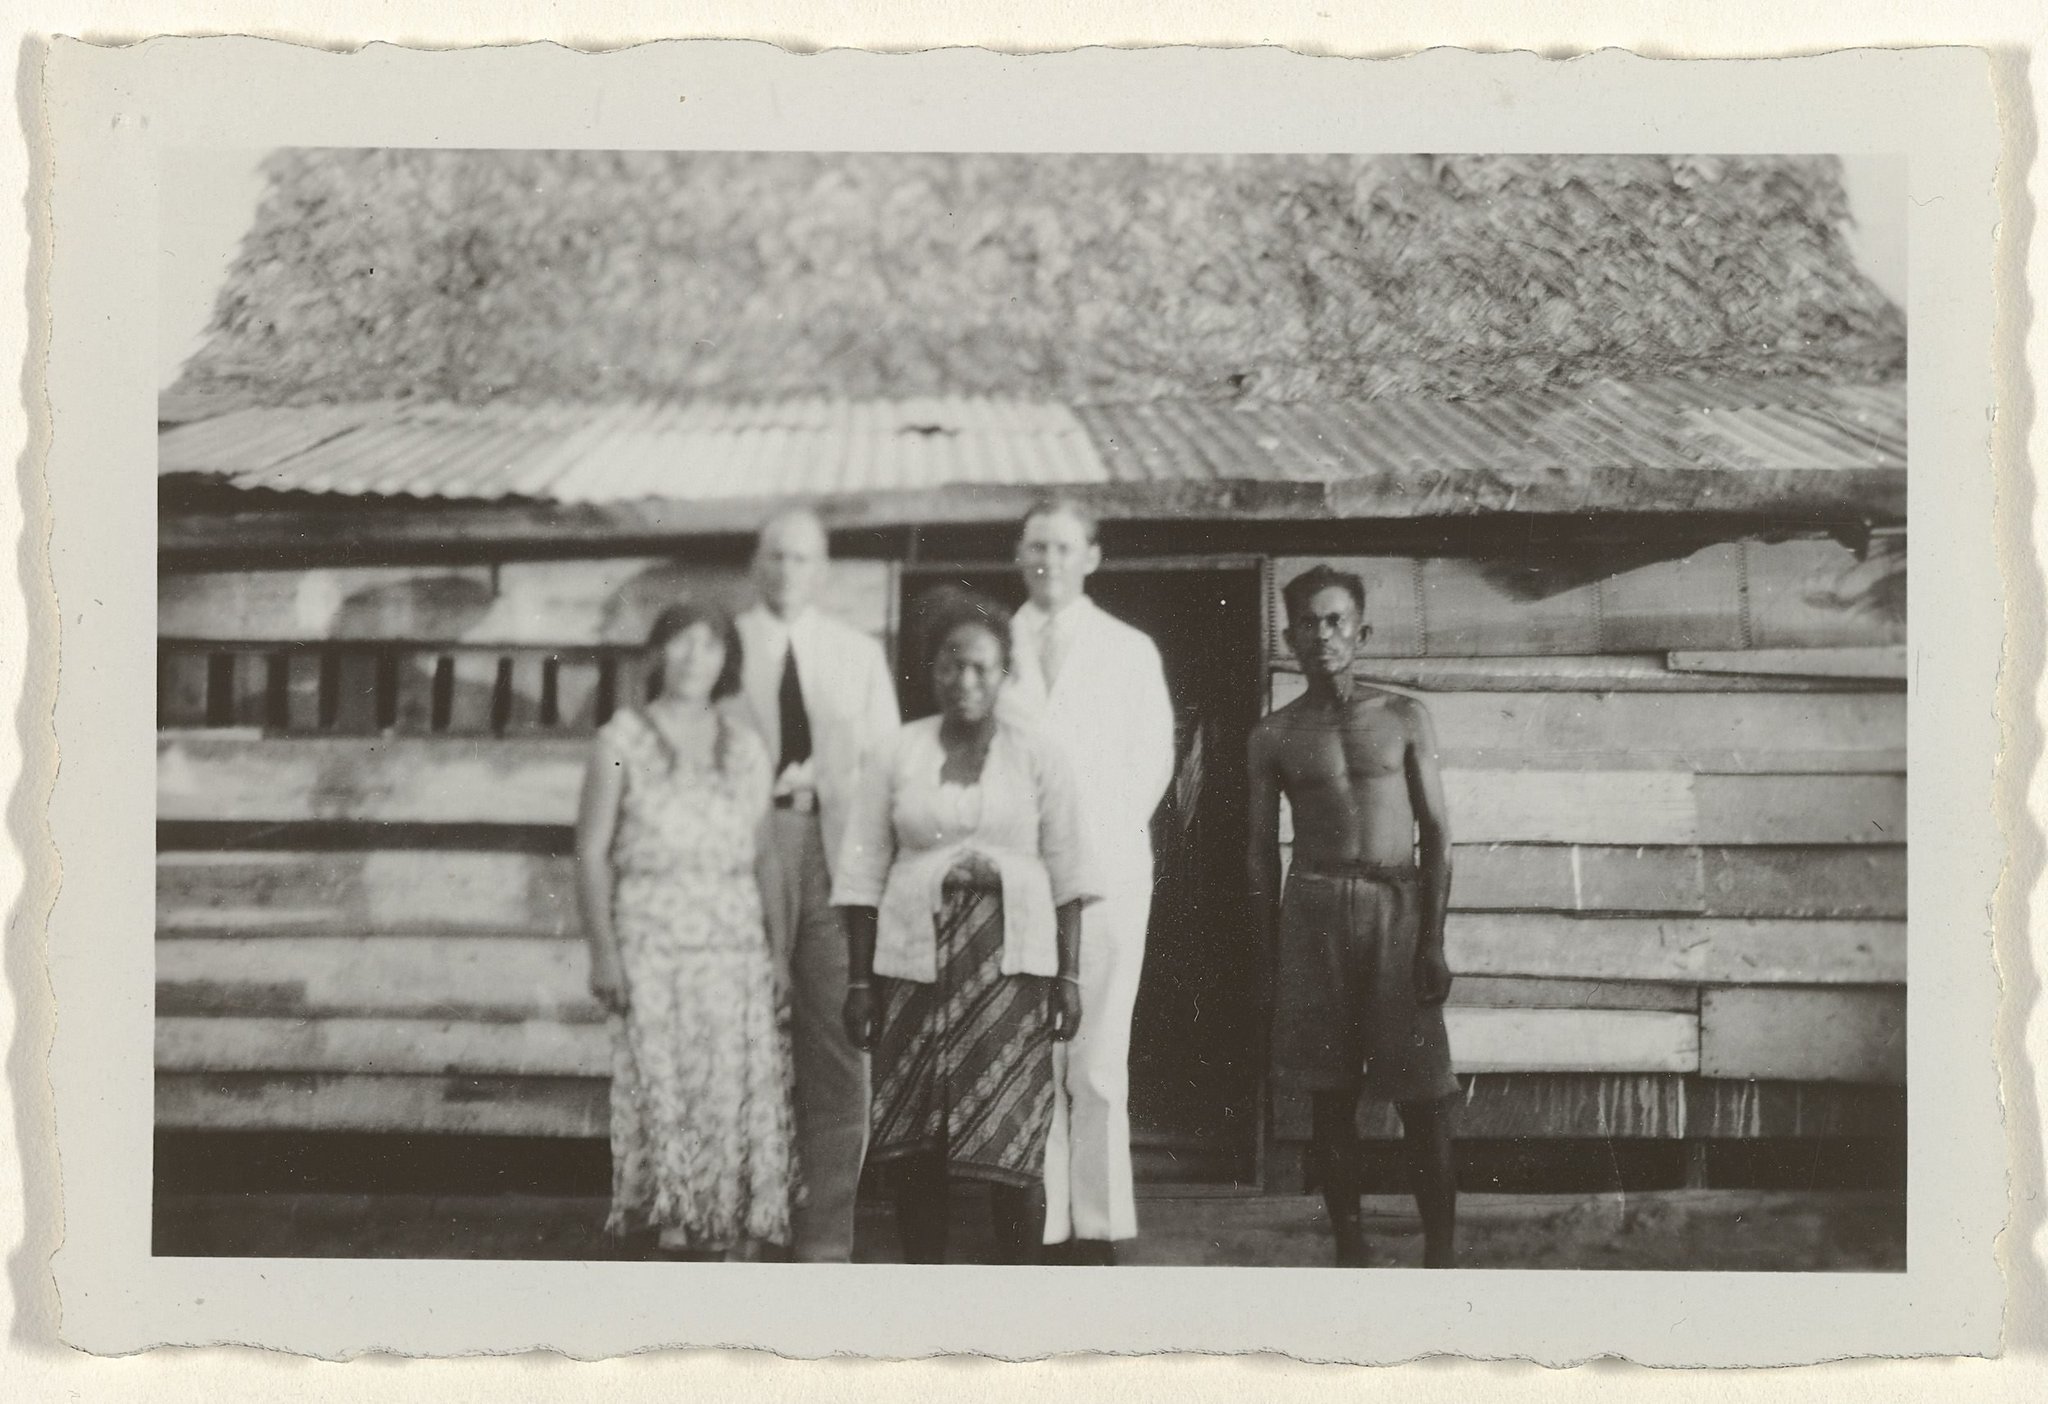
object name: photograph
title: Three European Men posing with a Javanese-Surinamese Couple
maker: Anonymous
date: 1929-1930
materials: photographic support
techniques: photography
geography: suriname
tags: village